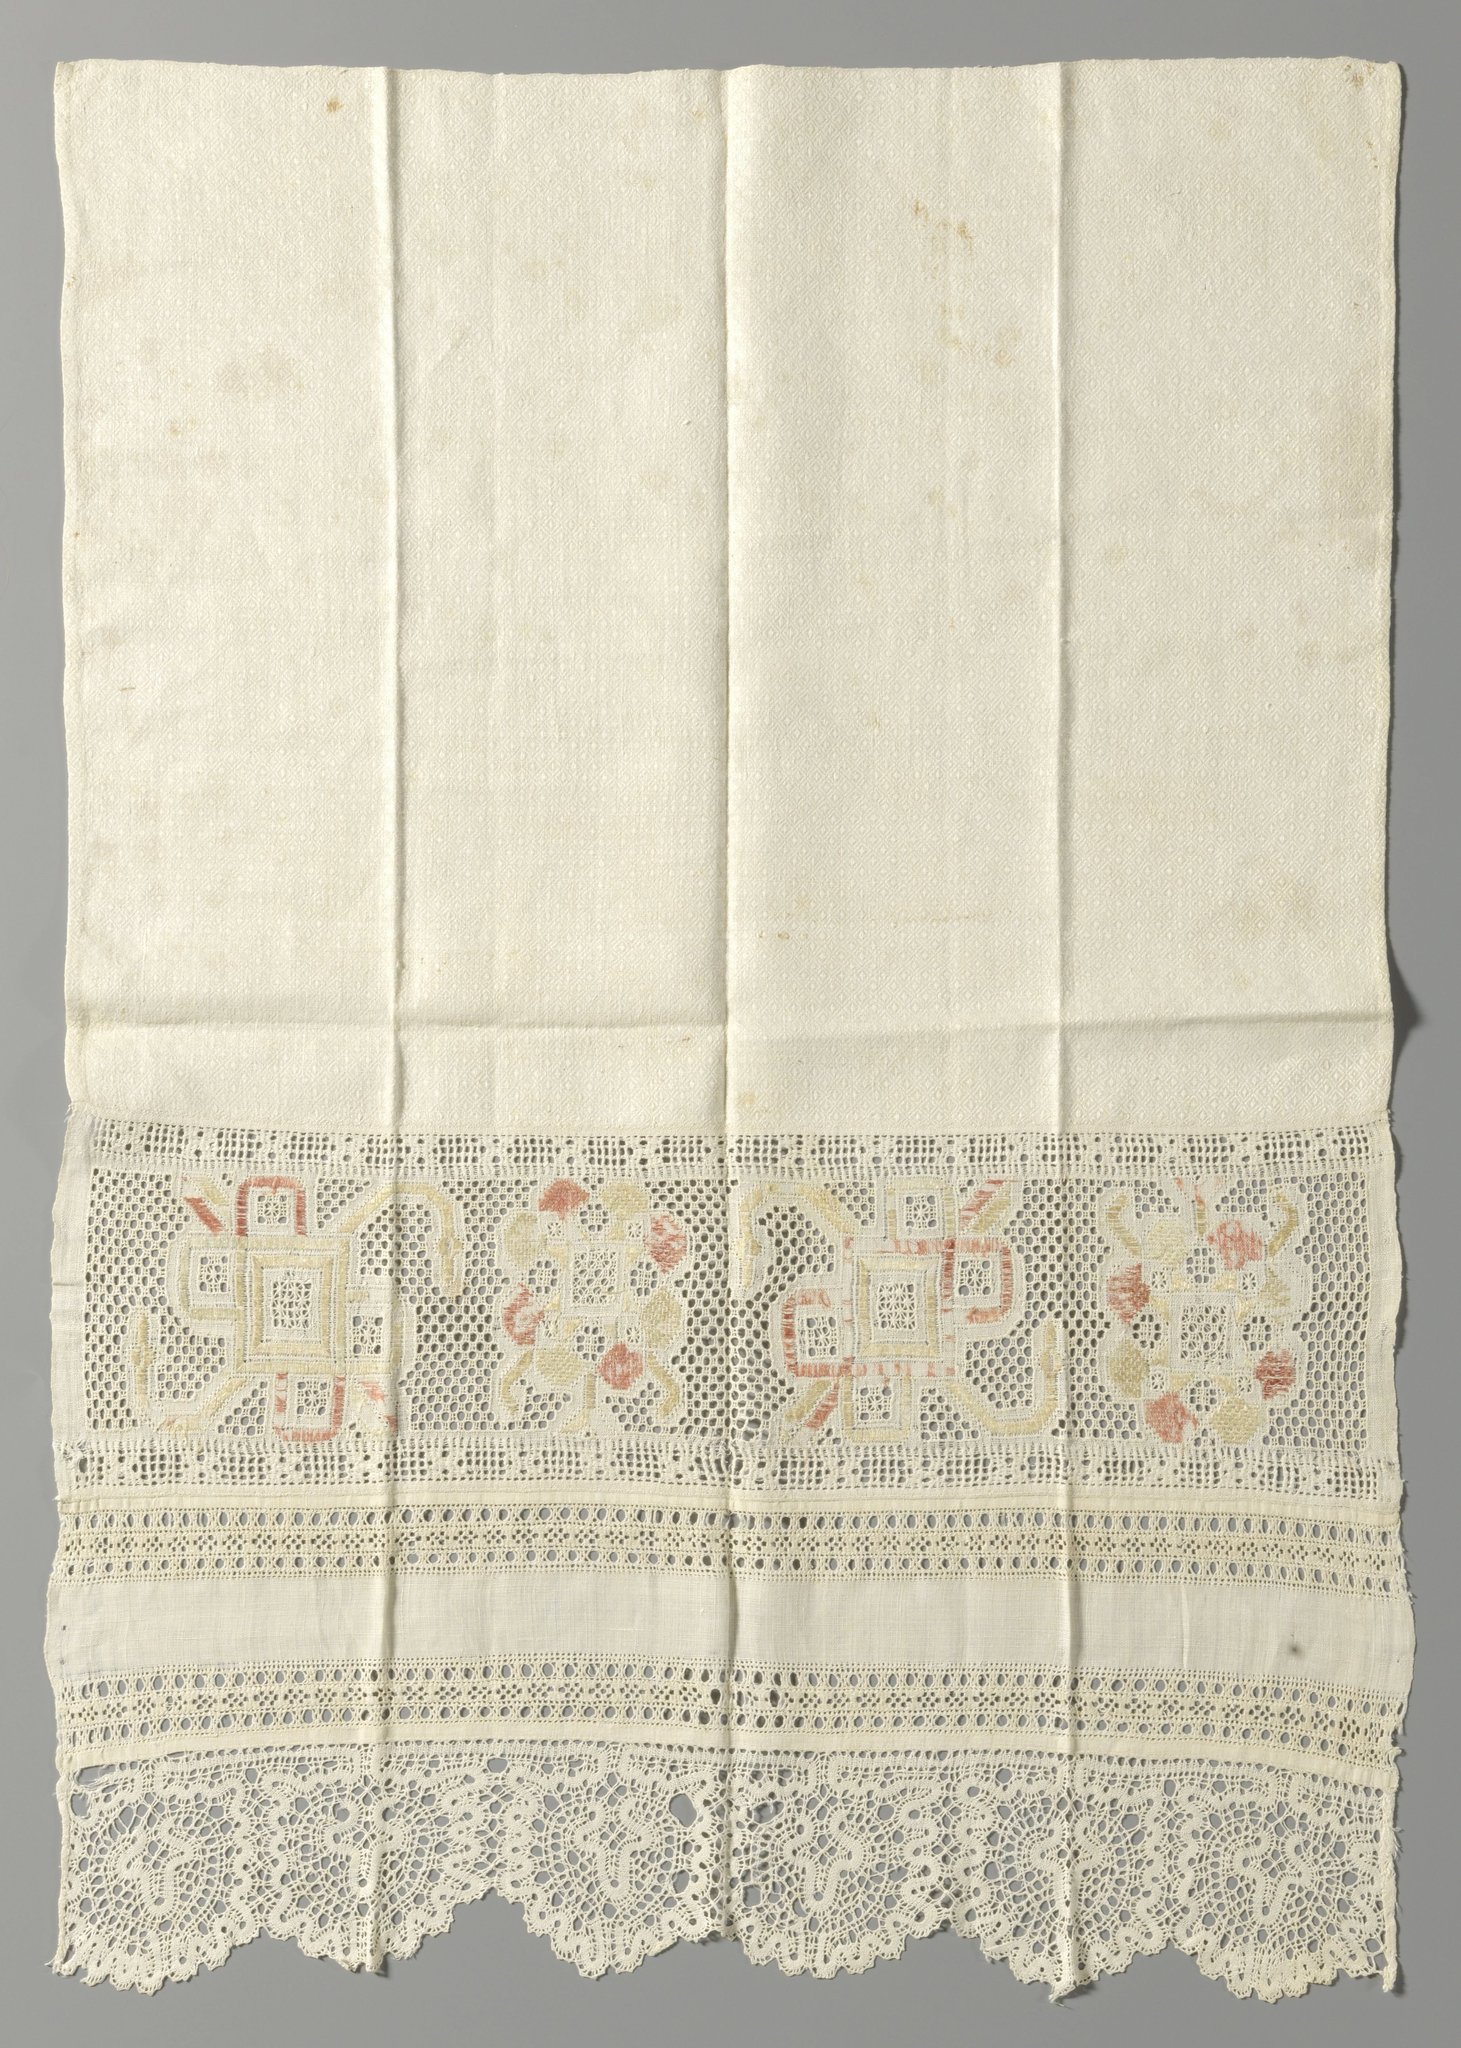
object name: towel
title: Lap van linnendamast met kantborduurwerk en kloskant met geometrische motieven voorzien van rood en goudkleurig borduurwerk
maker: Anonymous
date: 1600-1699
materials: linen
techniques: lace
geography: eastern europe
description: Lap van naturelkleurig linnendamast met aan één korte zijde open naaiwerk - werk met samengetrokken draden en werk met uitgetrokken draden - en een schulpenrand van kloskant: Oosteuropese kant. Aan het damast, met een patroon van kleine ruitjes, is een brede strook van werk met samengetrokken draden en werk met uitgetrokken draden genaaid. De vier geometrische motieven die hierbij zijn ontstaan zijn deels met rood en goud gekleurde draden voorzien van borduurwerk. Aan deze strook is een smallere linnen strook genaaid met werk met uitgetrokken draden langs de lange randen. Vervolgens is hieraan weer de schulprand van kloskant genaaid. De lap is mogelijk een deel van een handdoek.